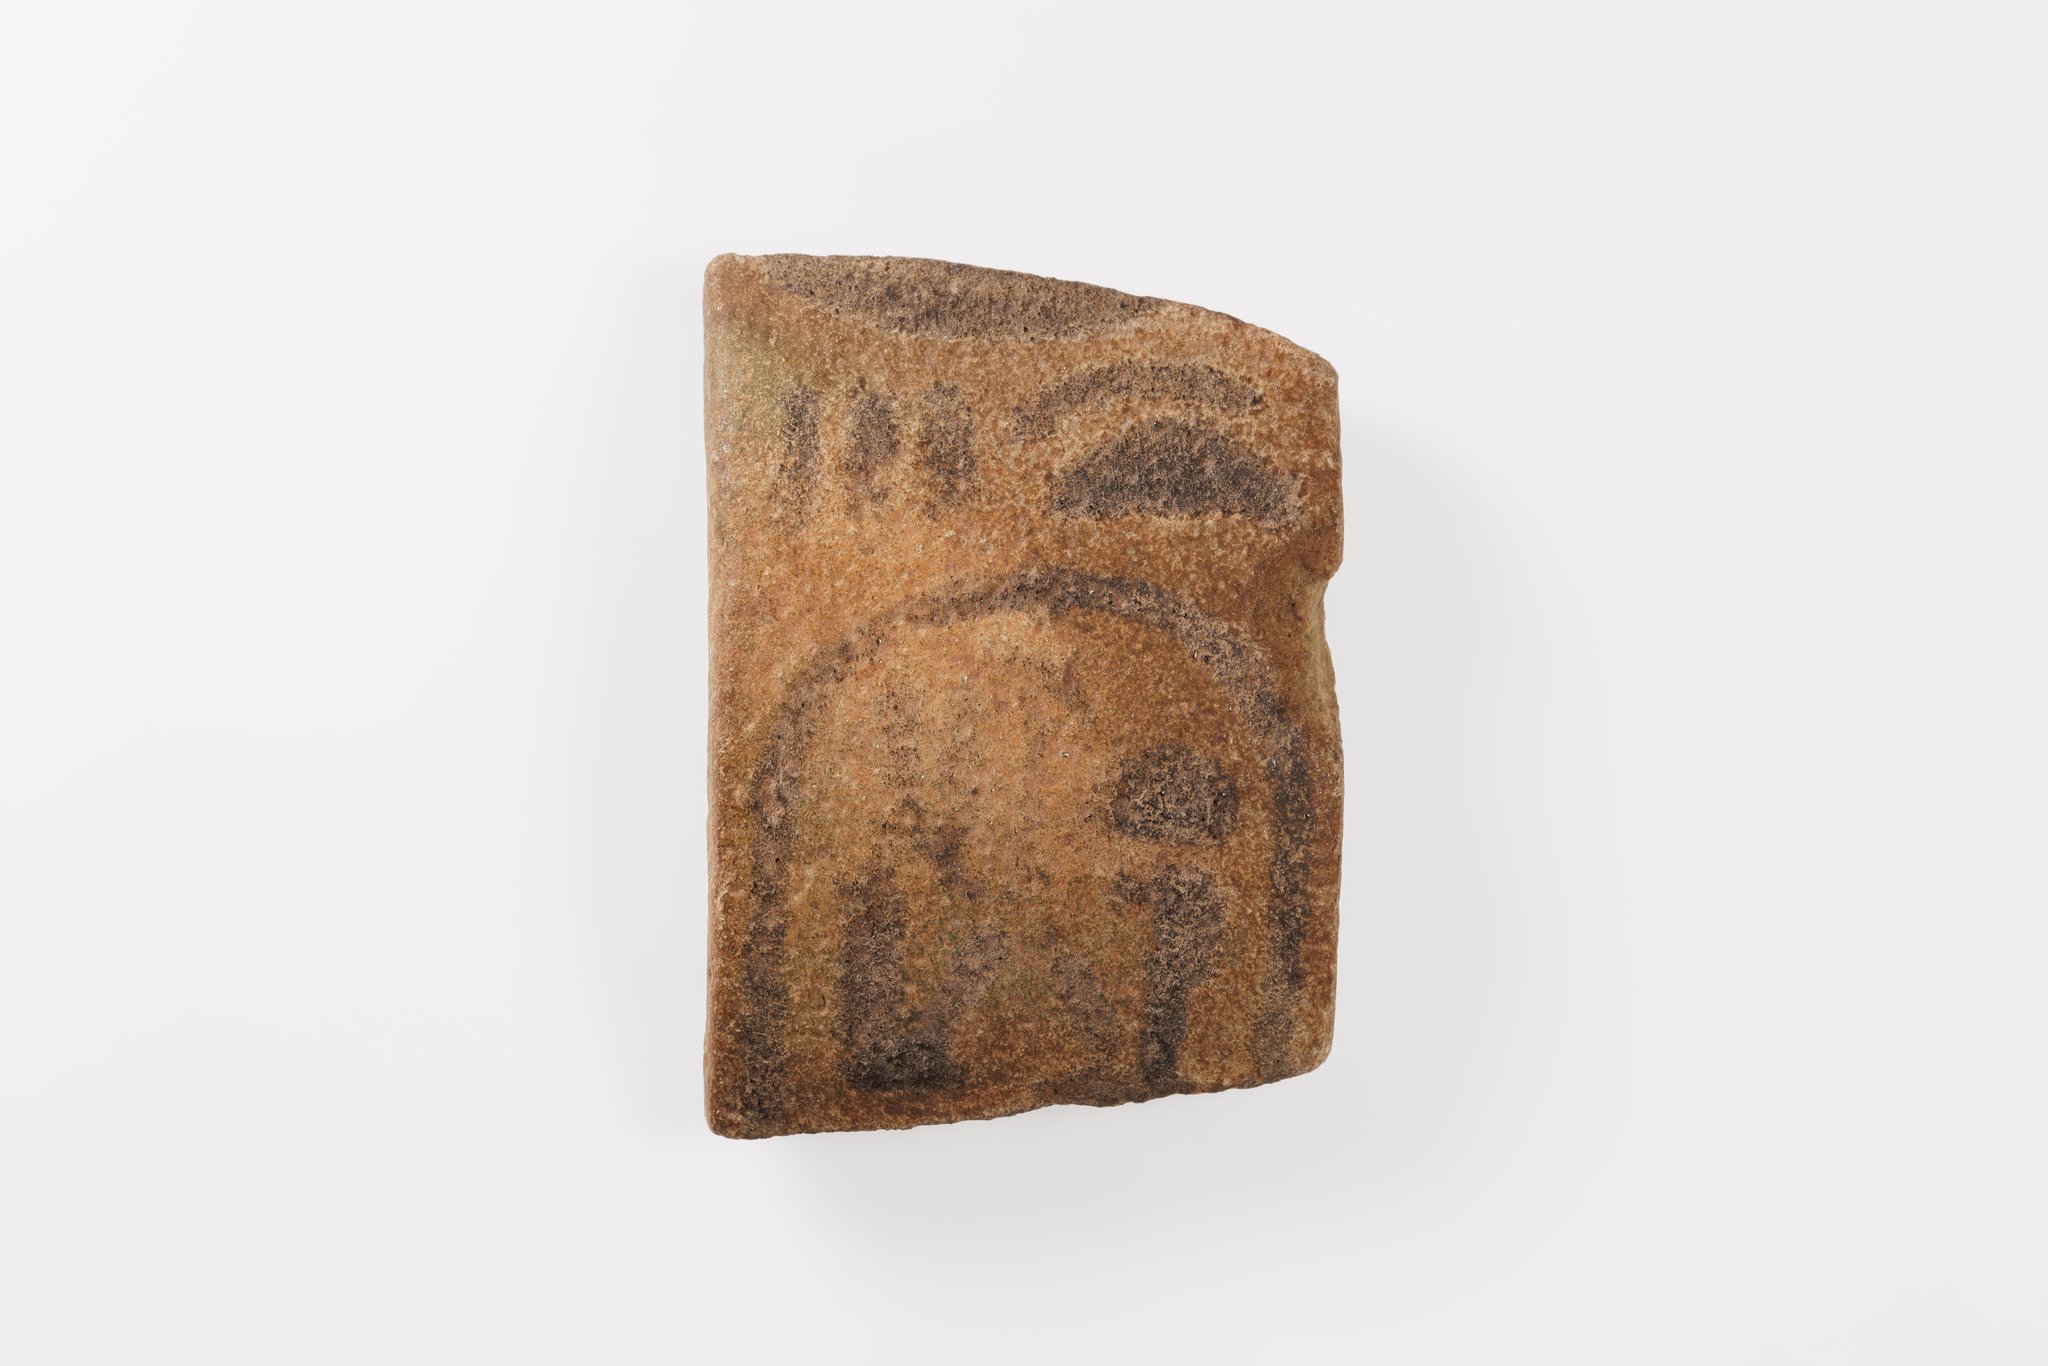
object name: votive bracelet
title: Fragment of a votive bracelet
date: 1295-1070 BCE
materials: faience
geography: egypt